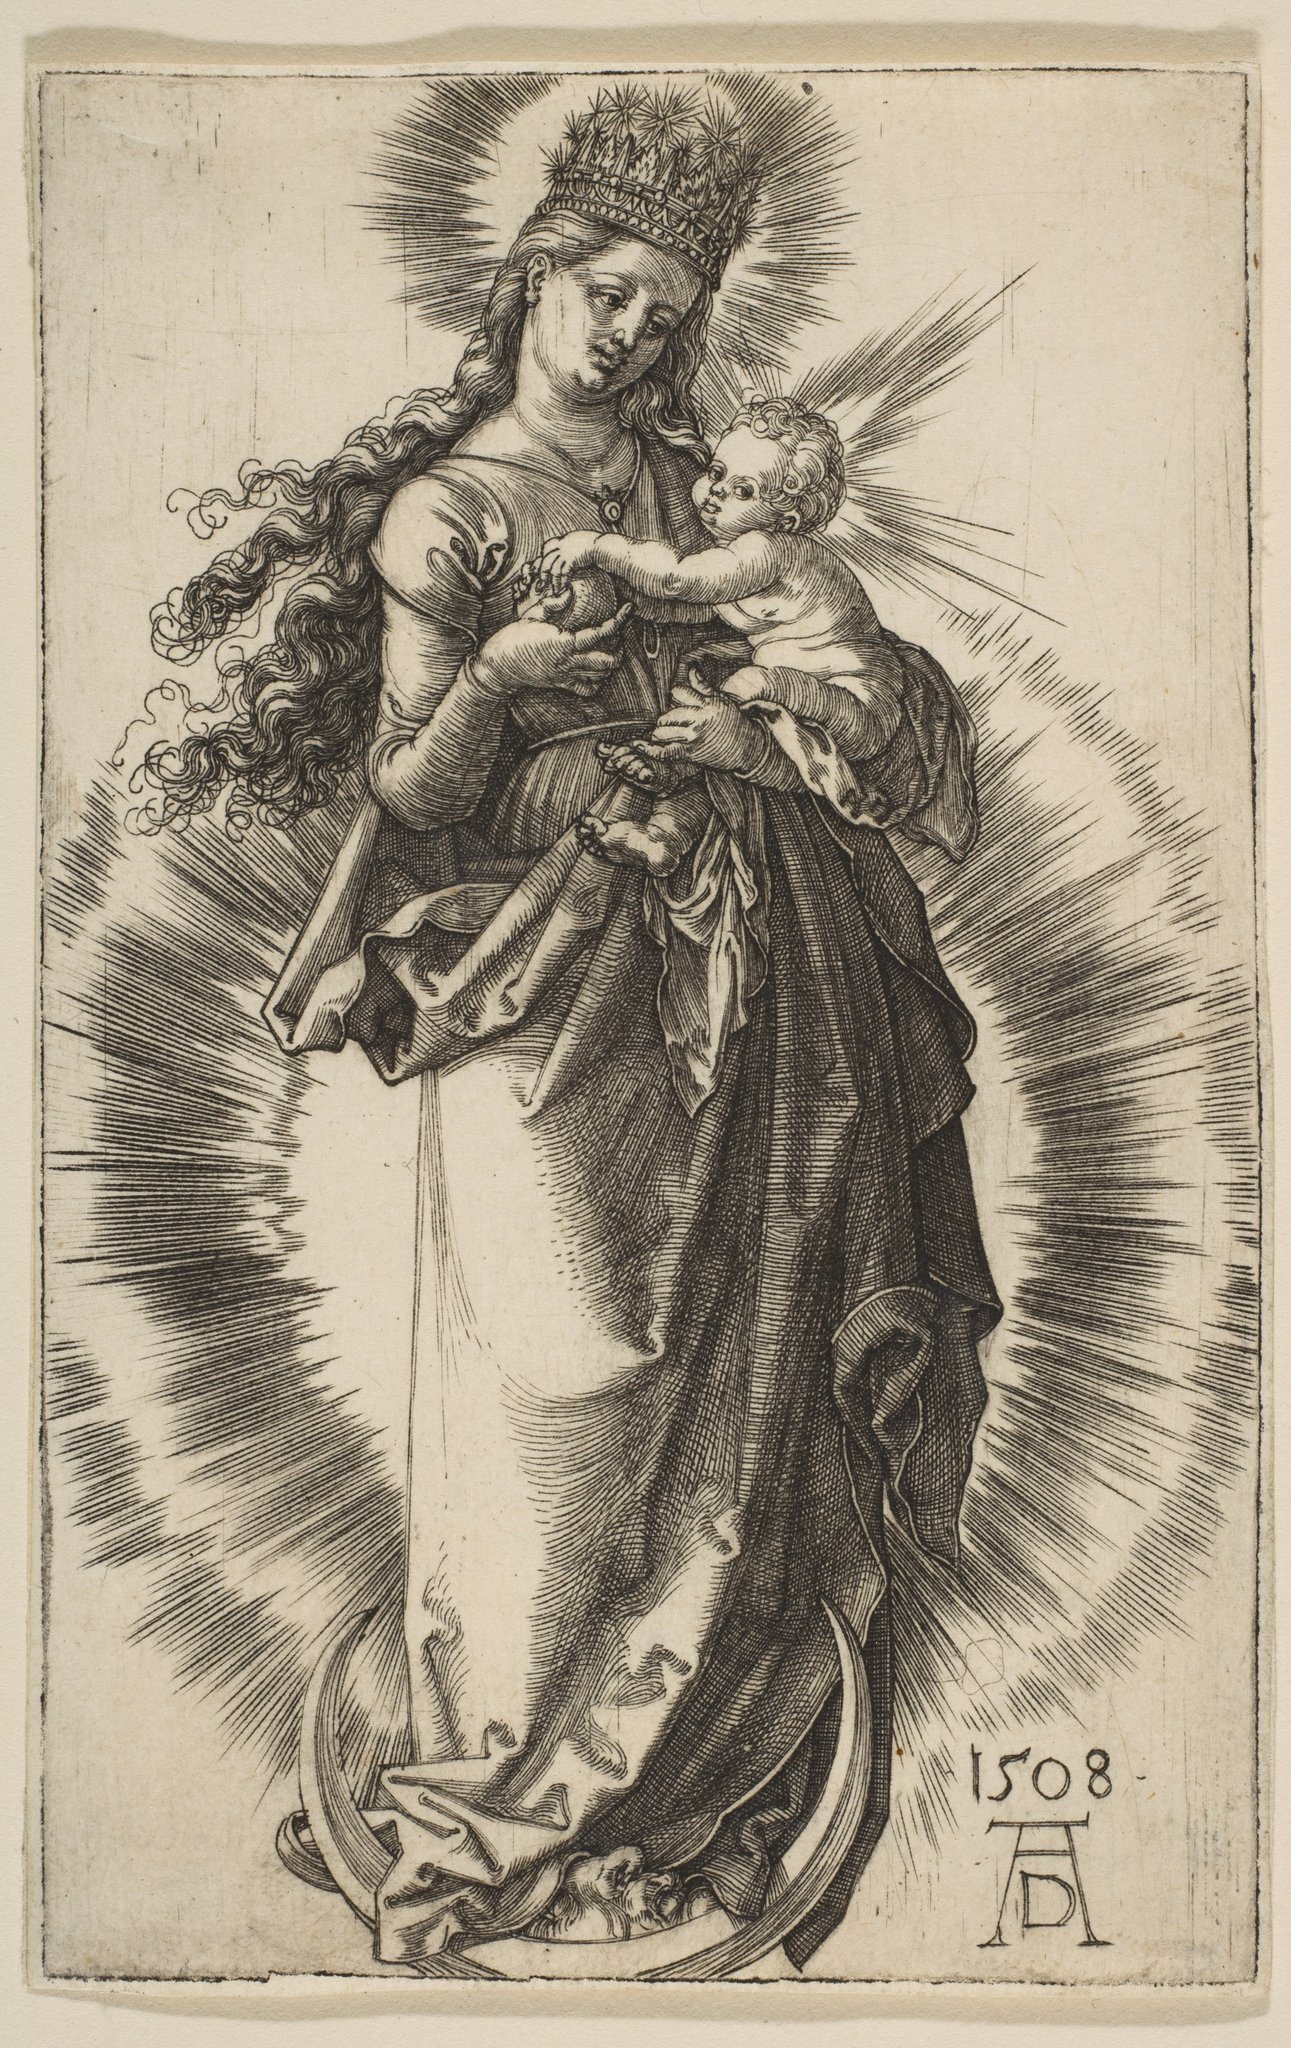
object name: print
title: Virgin on a Crescent with a Starry Crown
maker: albrecht dürer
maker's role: artist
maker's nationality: german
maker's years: 1471-1528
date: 1508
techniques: engraving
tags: madonna and child